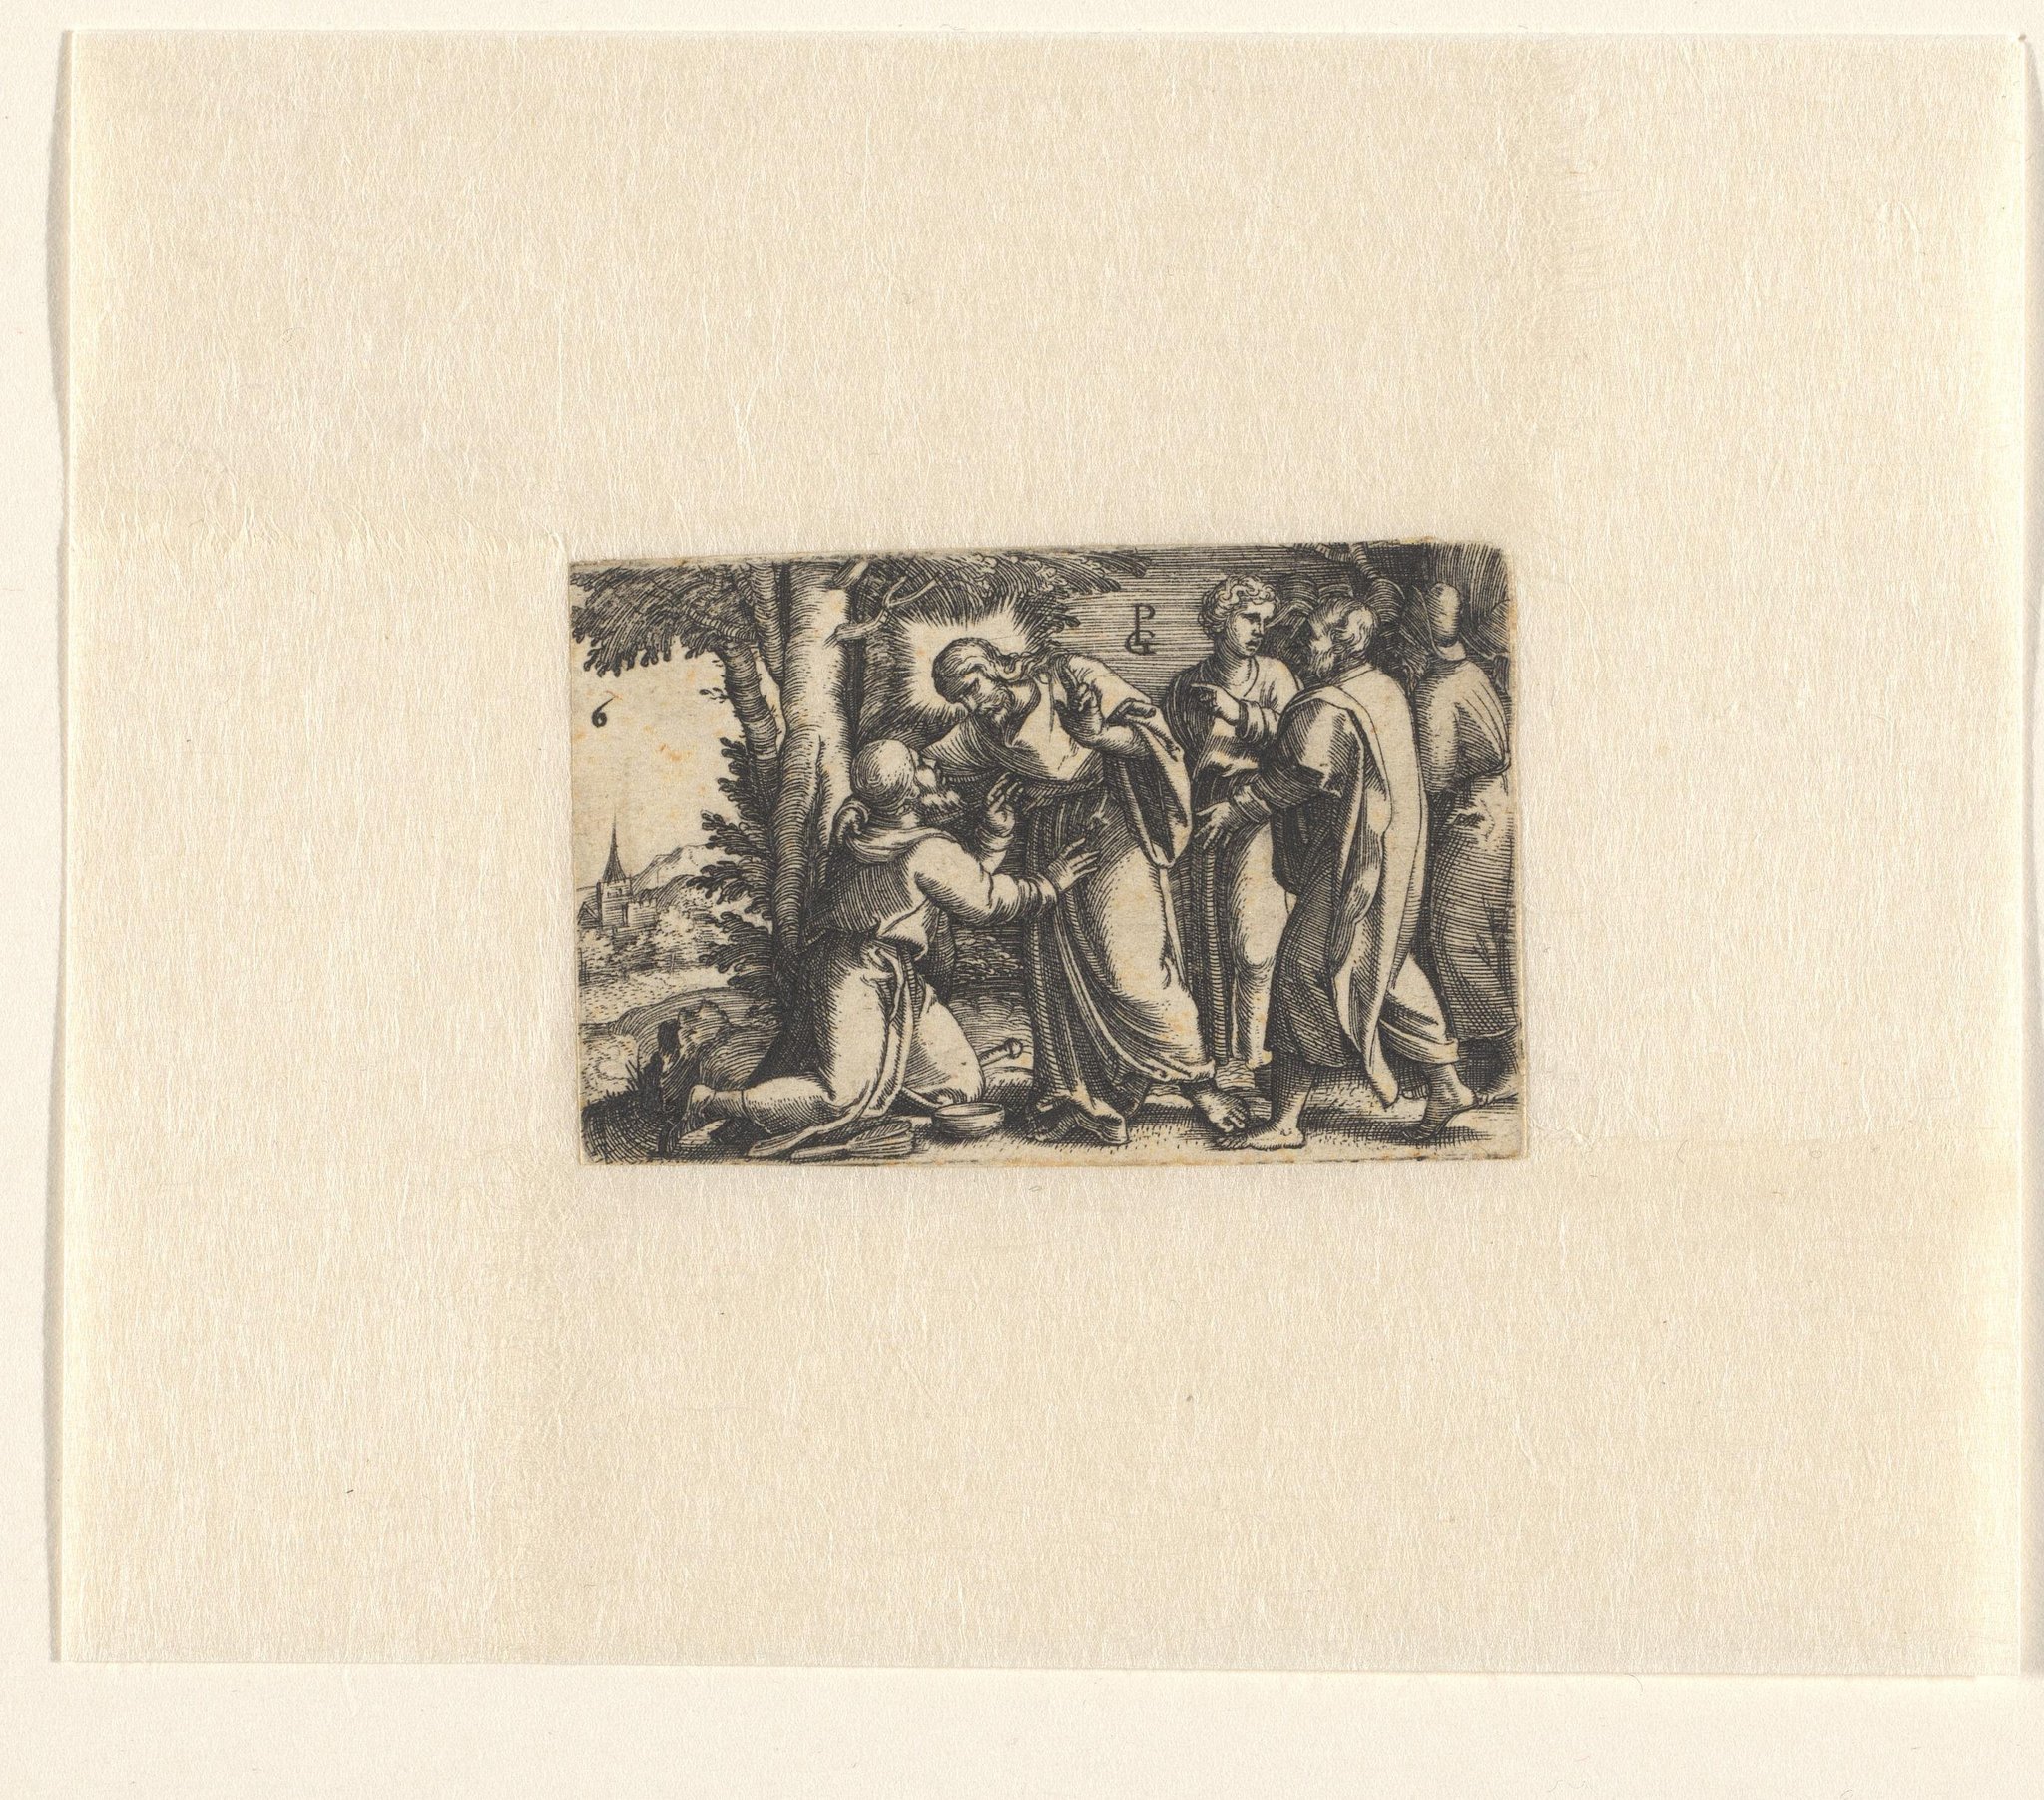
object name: print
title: Christus geneest een melaatse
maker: georg pencz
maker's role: draughtsman, painter, print maker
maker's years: 1500-1550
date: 1534-1535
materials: paper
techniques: engraving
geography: germany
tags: healing of one leper, who kneels before christ (matthew 8:1-4; mark 1:40-45; luke 5:12-16)